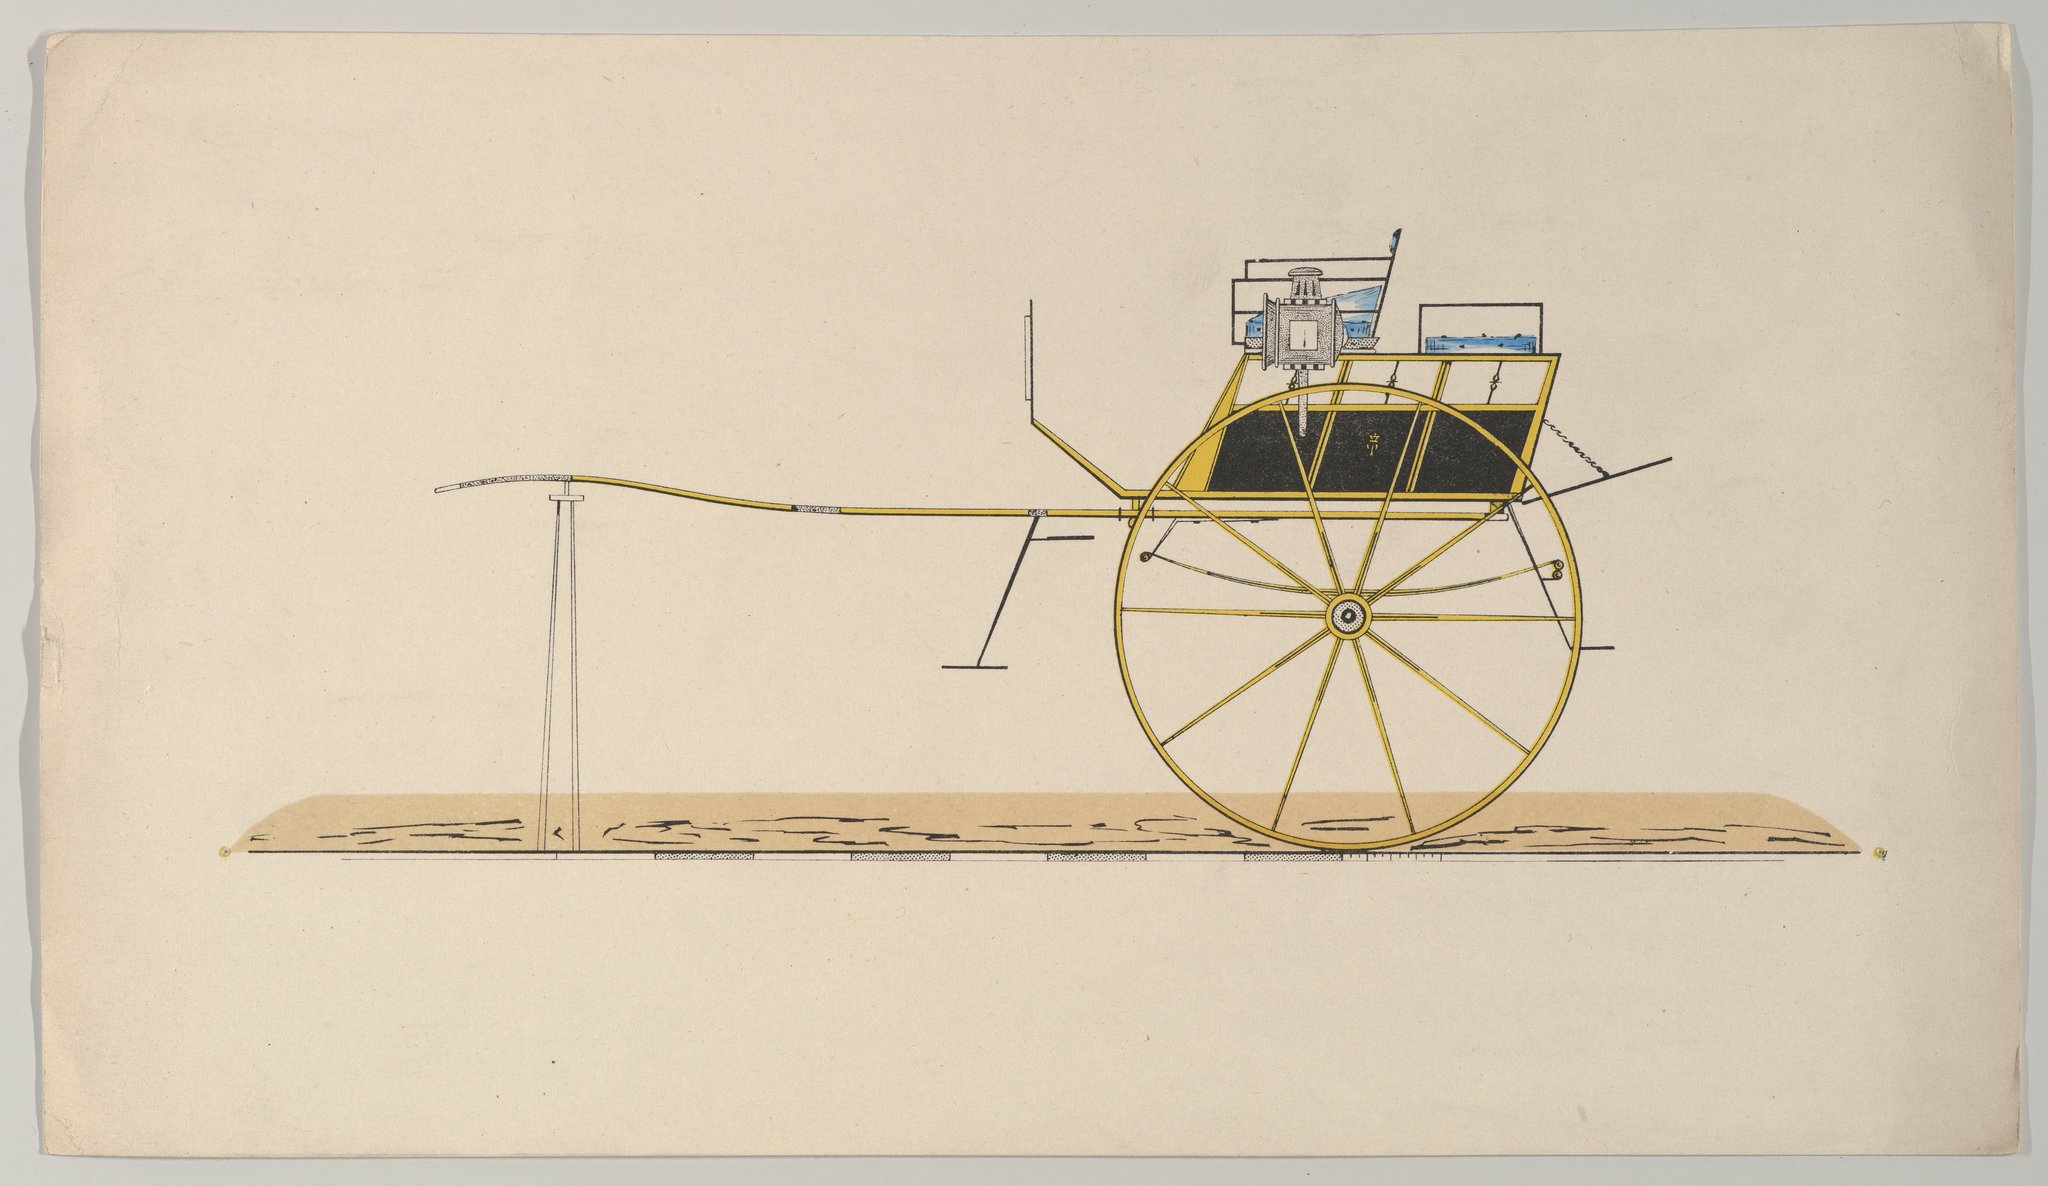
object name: print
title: Dog Cart (unnumbered)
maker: brewster & co.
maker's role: manufacturer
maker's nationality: american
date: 1850-1874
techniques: engraving, hand coloring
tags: carriages